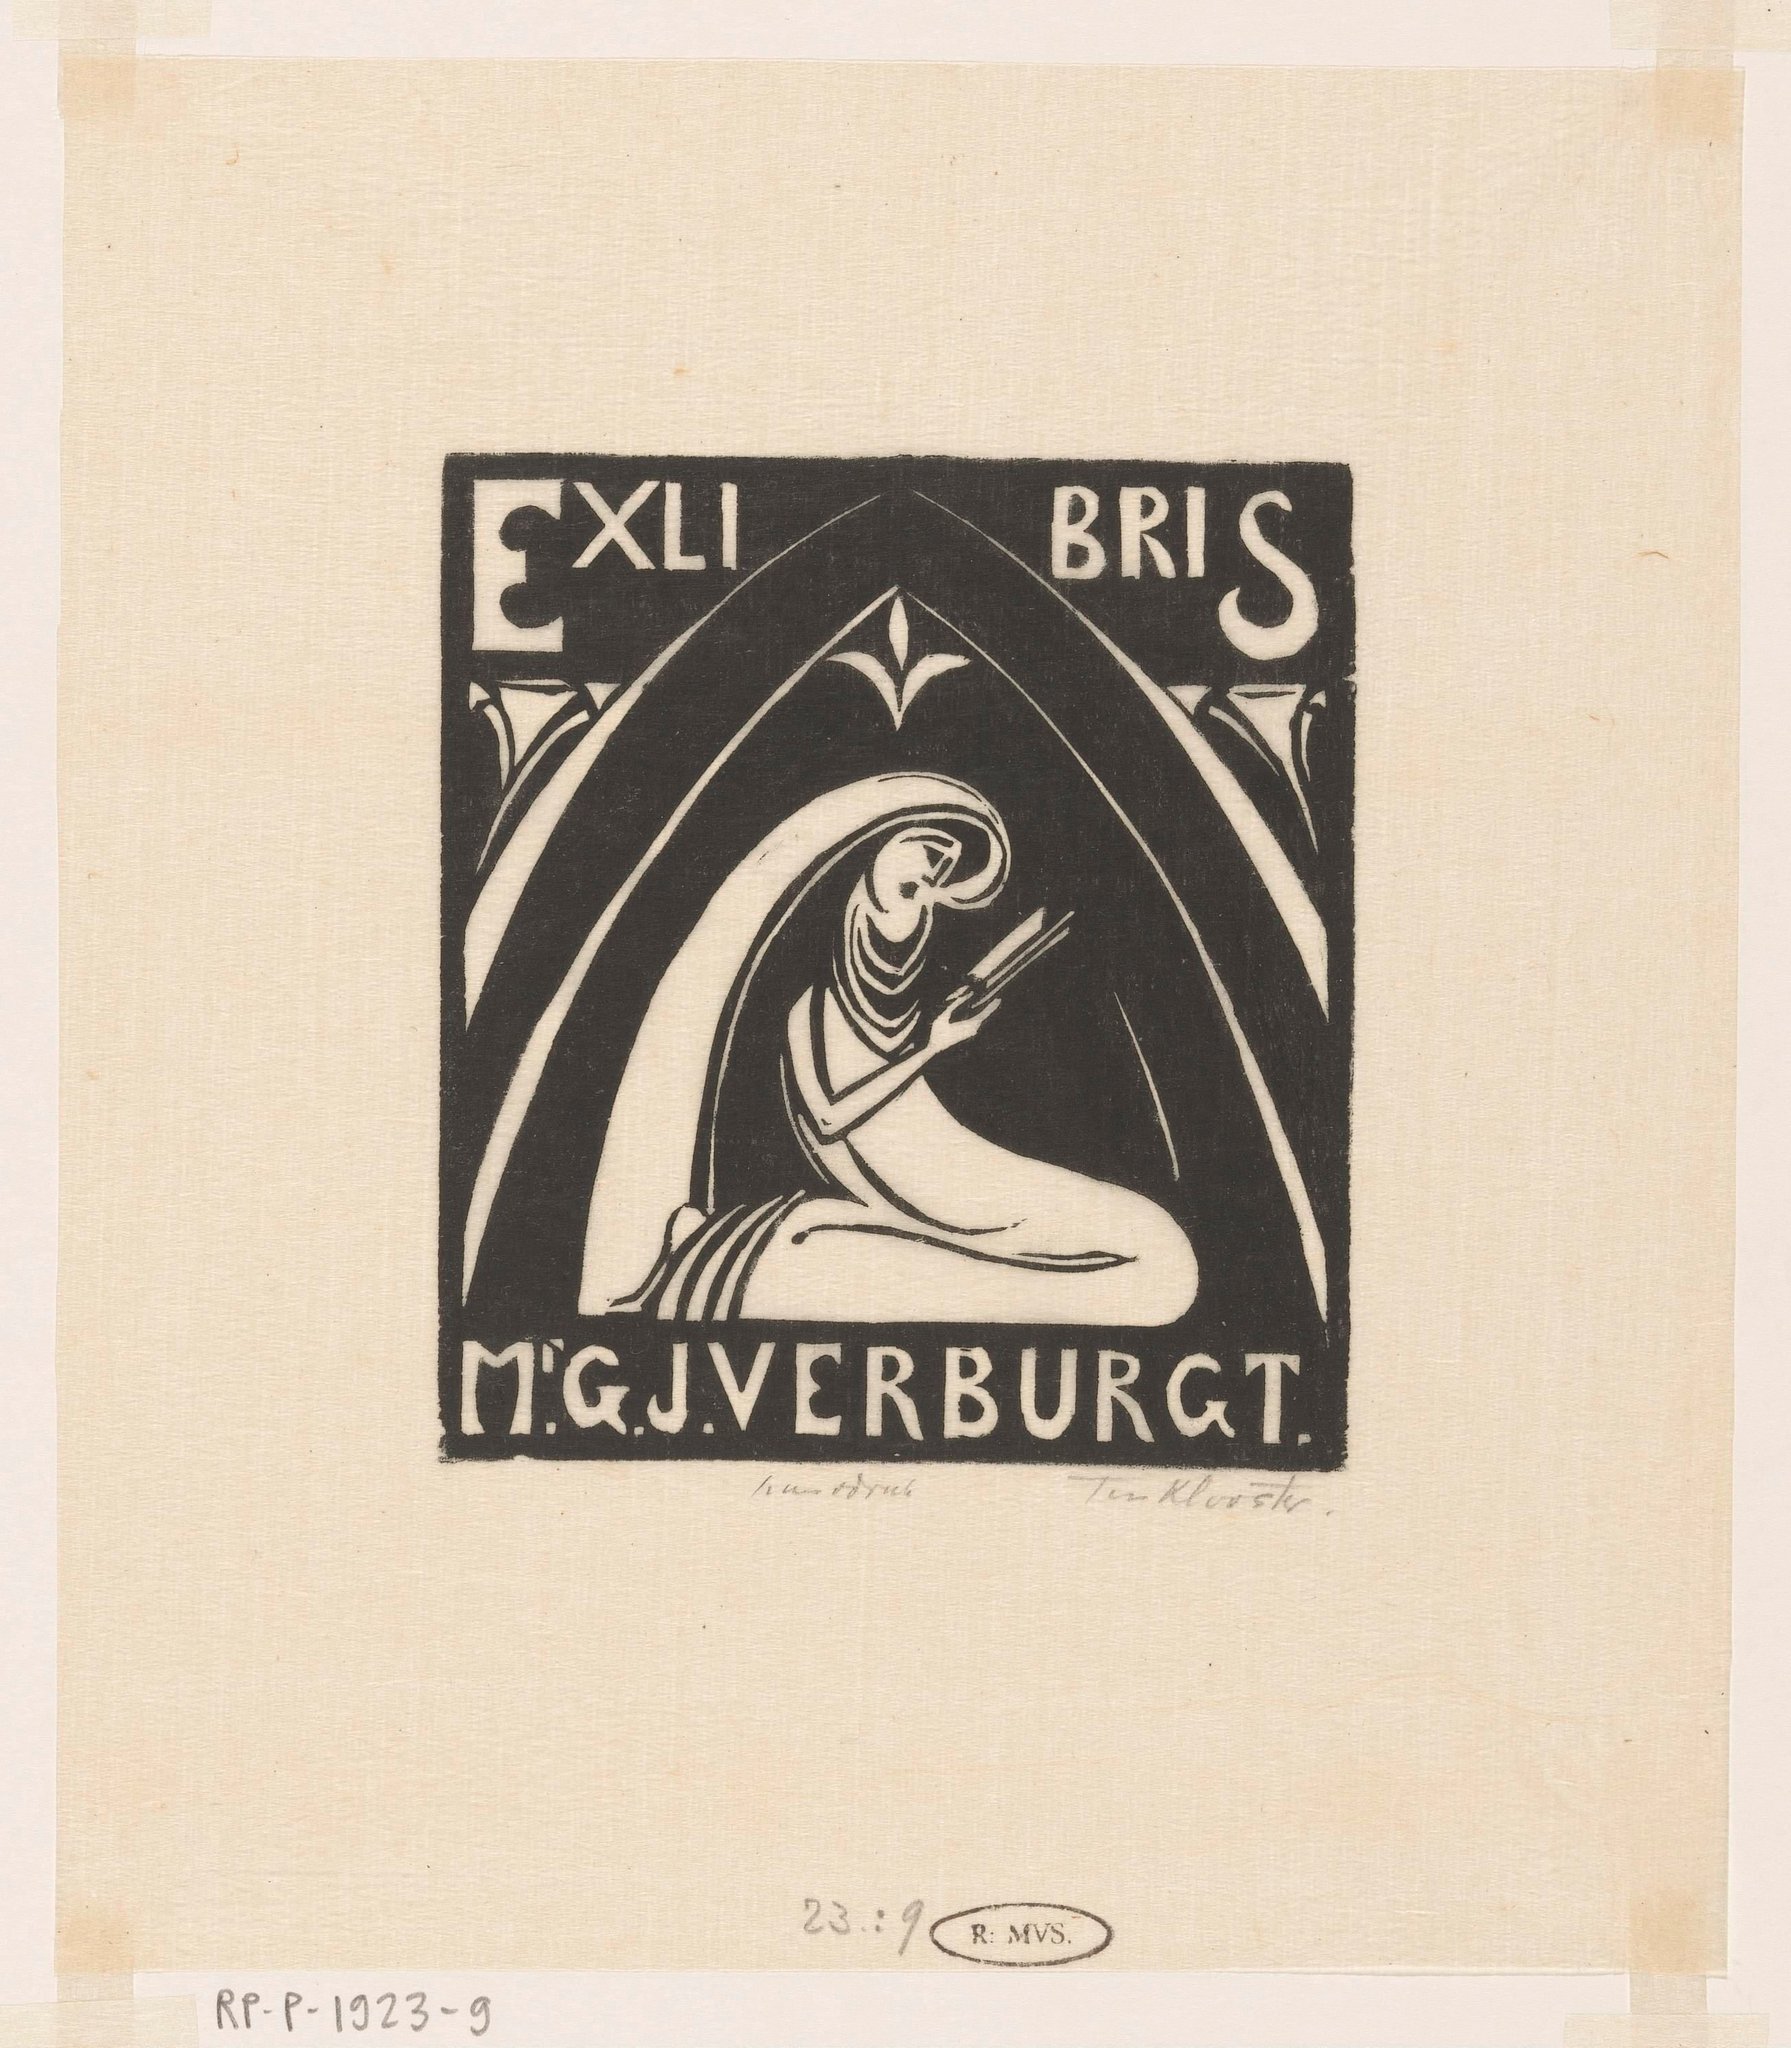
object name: bookplate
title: Ex libris van Gerrit-Jan Verburgt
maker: johannes frederik engelbert ten klooster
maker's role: draughtsman, print maker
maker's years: 1873-1940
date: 1922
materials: paper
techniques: woodcut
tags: the hague, reading, kneeling figure - aa - female human figure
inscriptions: collector's mark: Lugt 2228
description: Een geknielde vrouw met een opengeslagen boek in haar handen.